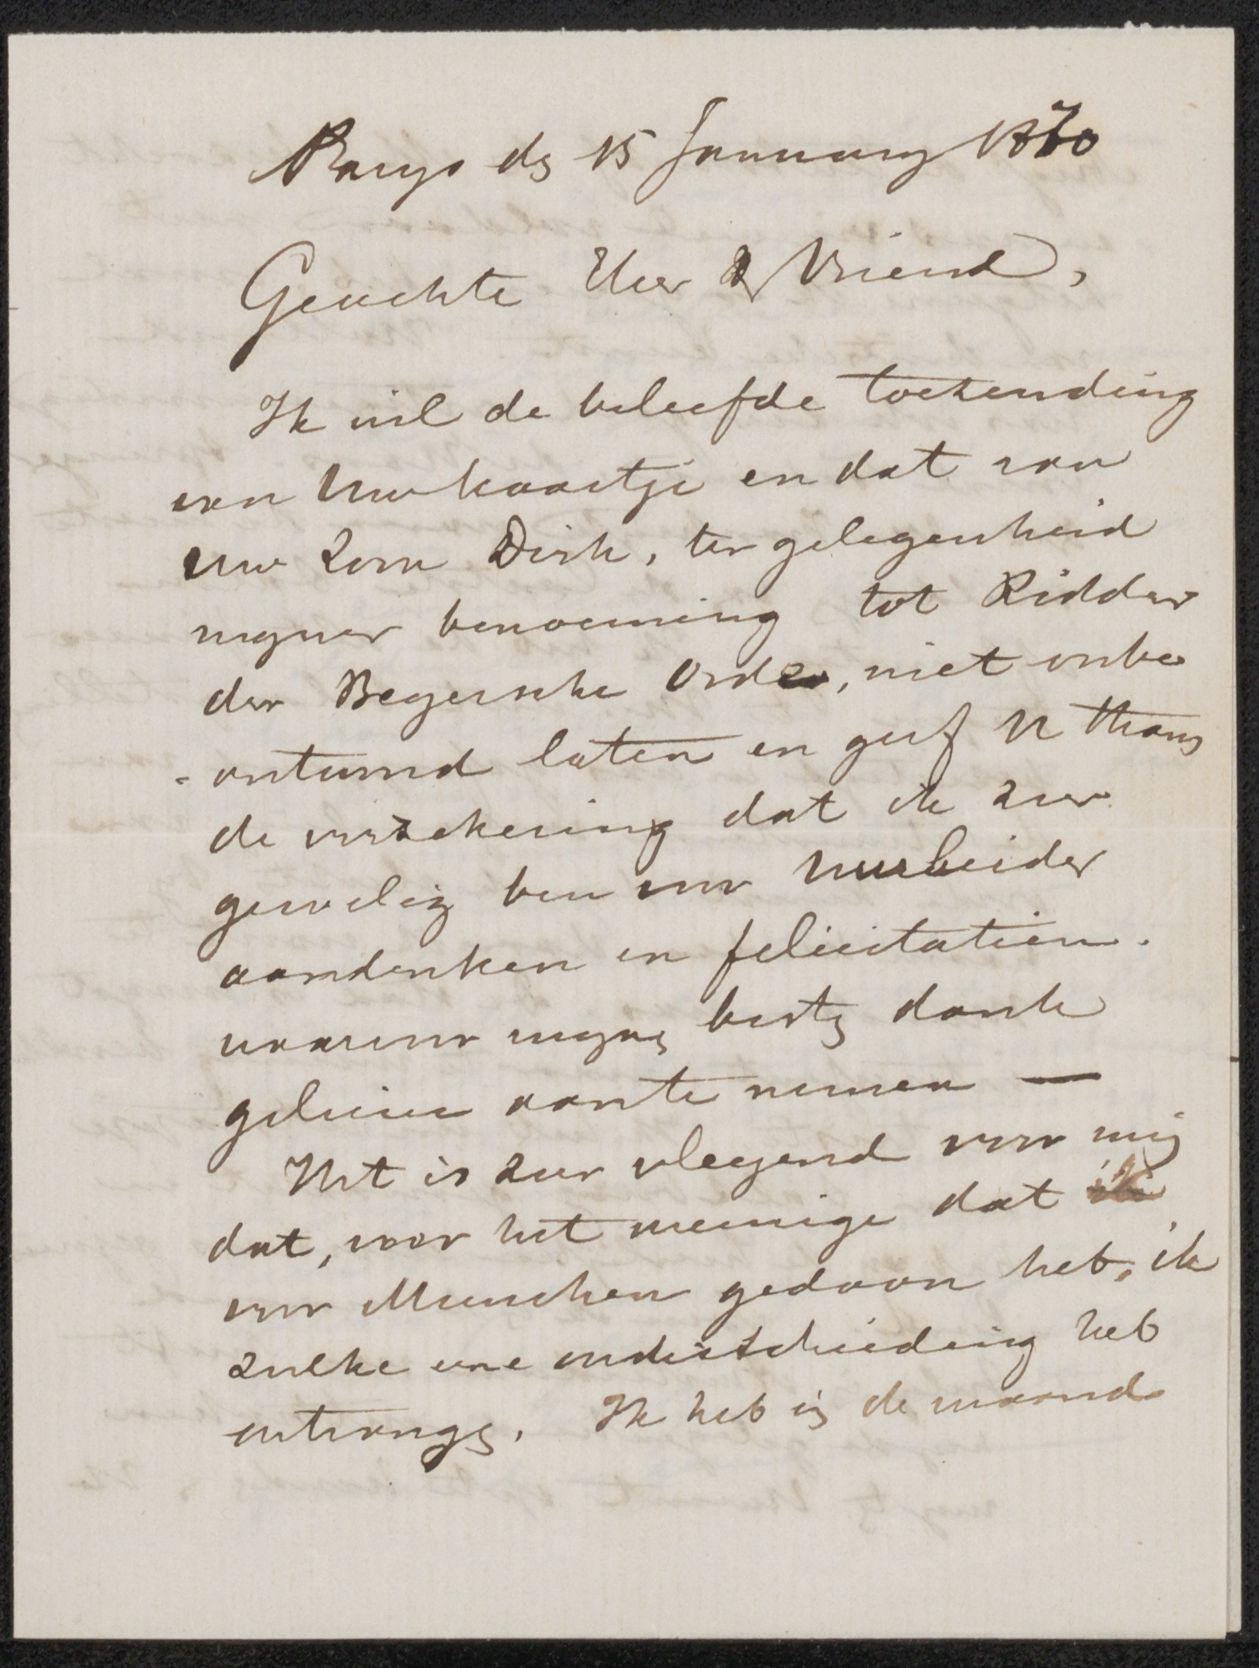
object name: letter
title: Brief aan Ary Johannes Lamme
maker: j. wittering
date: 1870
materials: ink, paper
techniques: pen, writing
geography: paris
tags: print maker, draughtsman, lourens alma tadema, paris, sculptor, cornelia marjolin-scheffer, dordrecht, ary johannes lamme, rotterdam, dirk arie lamme, painter, johannes hubertus leonardus de haas, exhibition ~ art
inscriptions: collector's mark: Lugt 2228